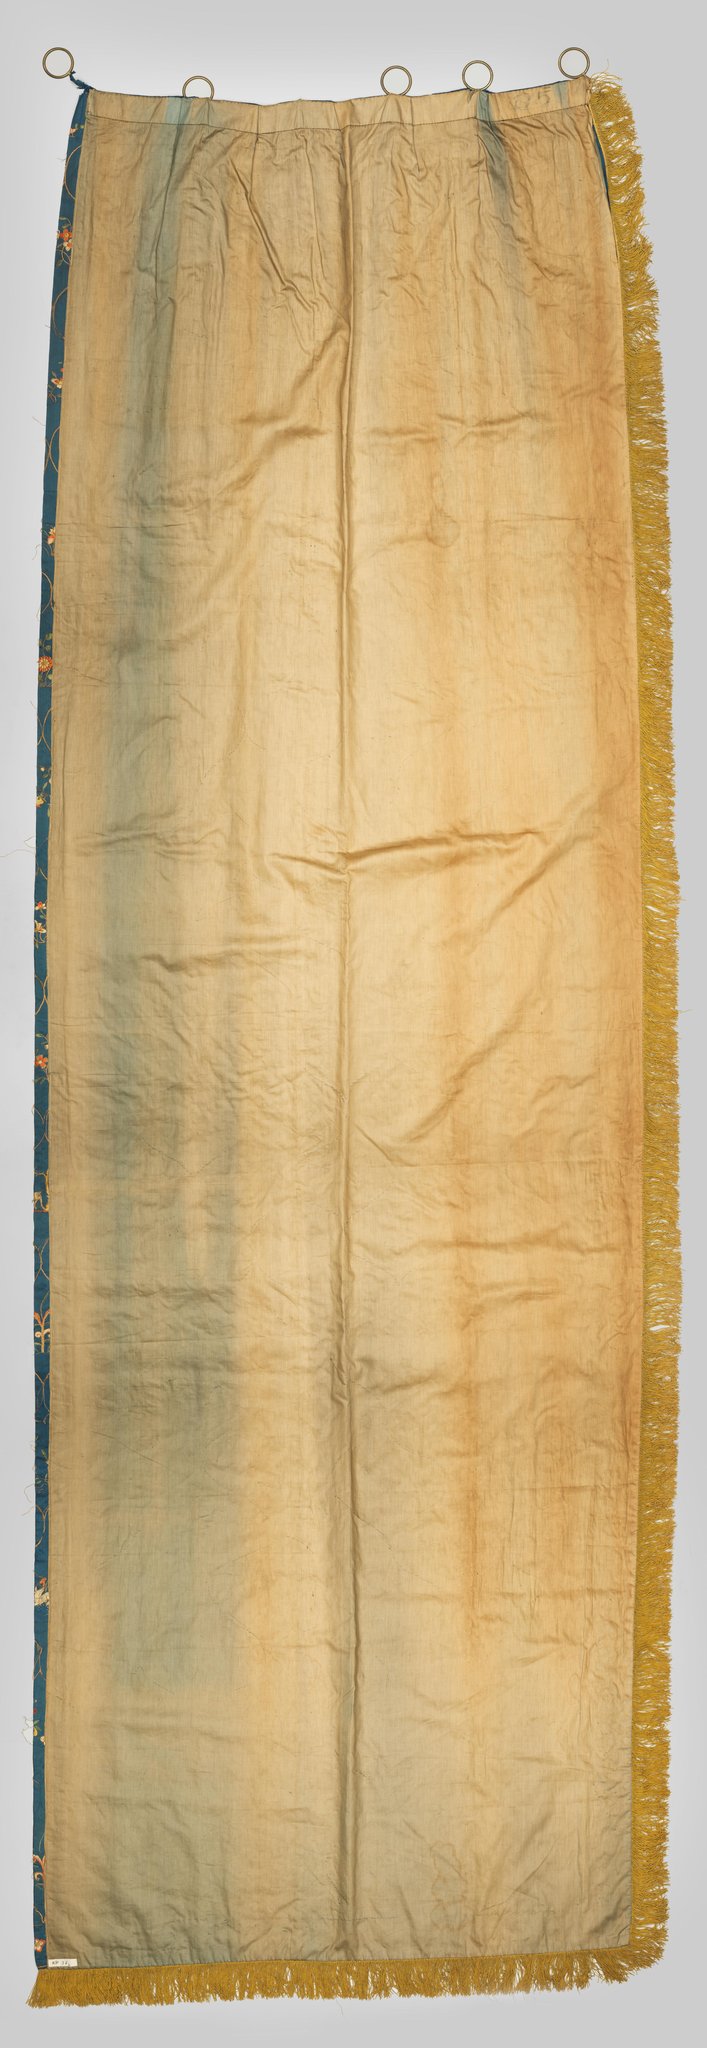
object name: curtain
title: Gordijn van blauw zijde met borduurwerk in Chinese trant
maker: Anonymous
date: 1880-1900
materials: brass, metal thread, silk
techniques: embroidered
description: Gordijn van blauw zijde met borduursel in zijde en goudkleurig metaaldraad in Chinese trant. Mogelijk in China geborduurd. Donkerblauw fond met florale motieven, dieren en mythische wezens in spitsovalen van metaaldraad. Voorzien van vijf messing ringen aan de bovenzijde, versierd met franjes langs twee zijden. Één messing ring ontbreekt. Gevoerd.